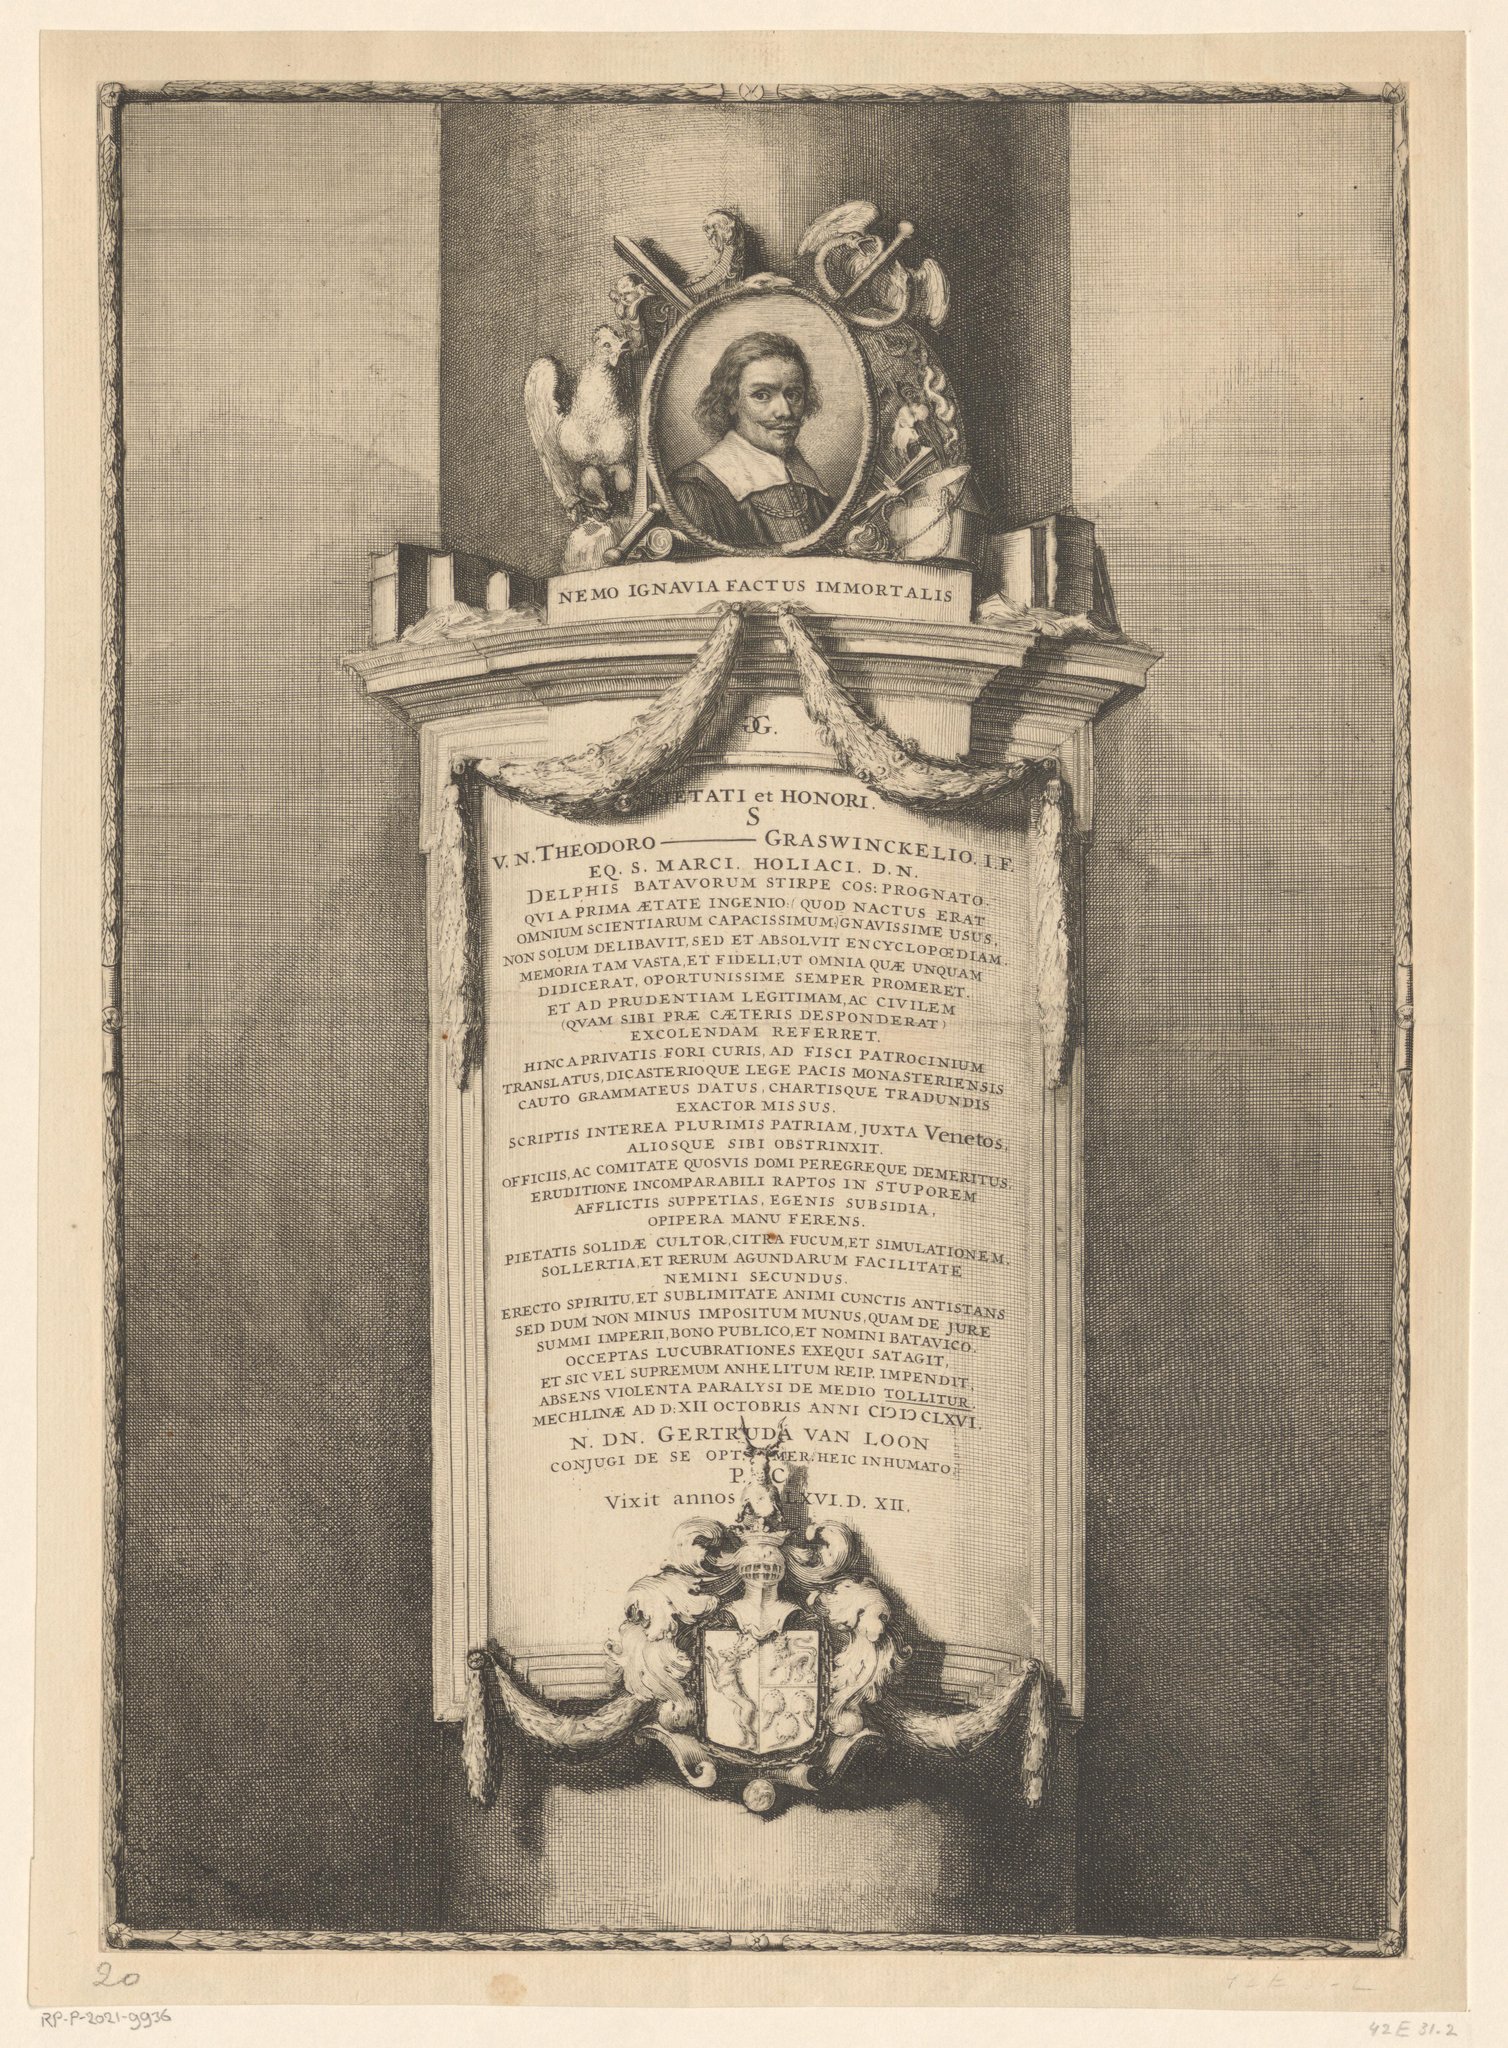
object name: print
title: Grafmonument van Theodorus Johannes Dirk Graswinckel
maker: theodor matham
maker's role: draughtsman, print maker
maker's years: 1605-1676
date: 1666-1676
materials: paper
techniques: engraving, etching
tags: delft, theodorus johannes dirk graswinckel, historical persons, grave, tomb, armorial bearing, heraldry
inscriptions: collector's mark: Lugt 2228